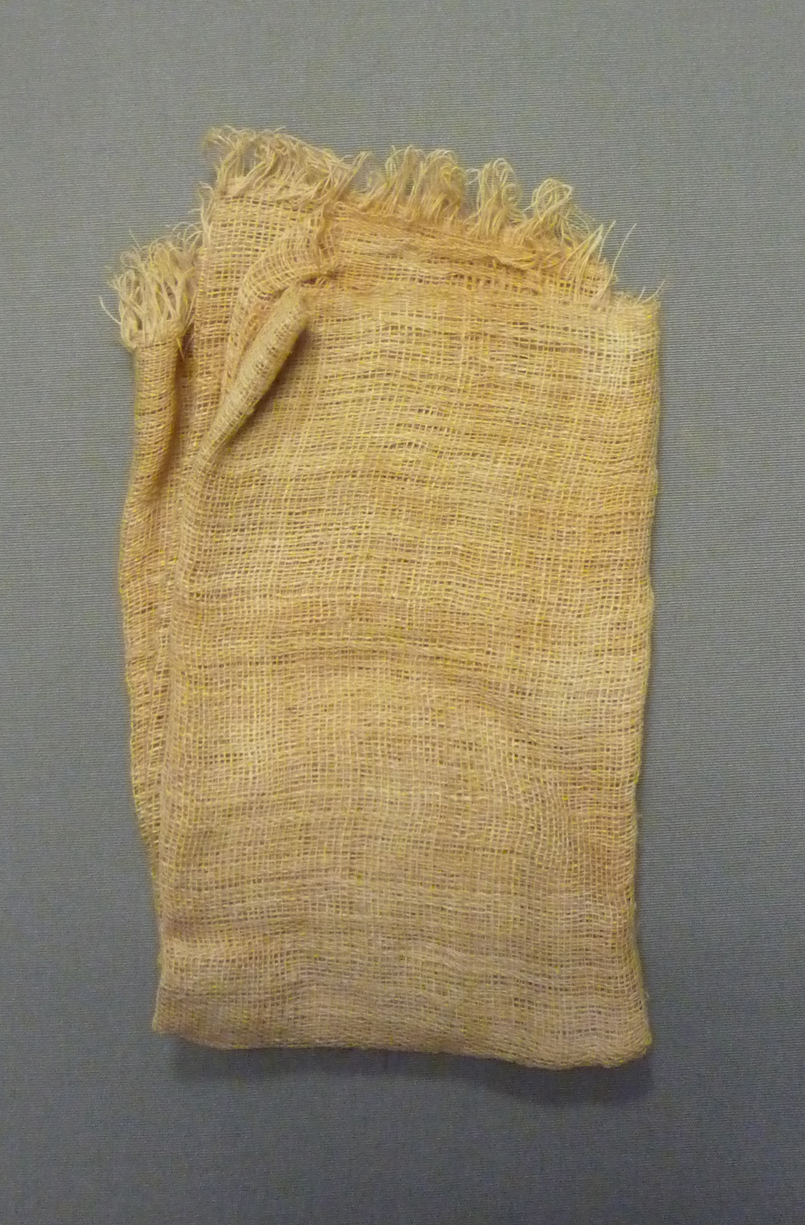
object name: linen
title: Model Sheet from a Foundation Deposit for Hatshepsut's Temple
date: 1479-1458 BCE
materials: linen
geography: egypt